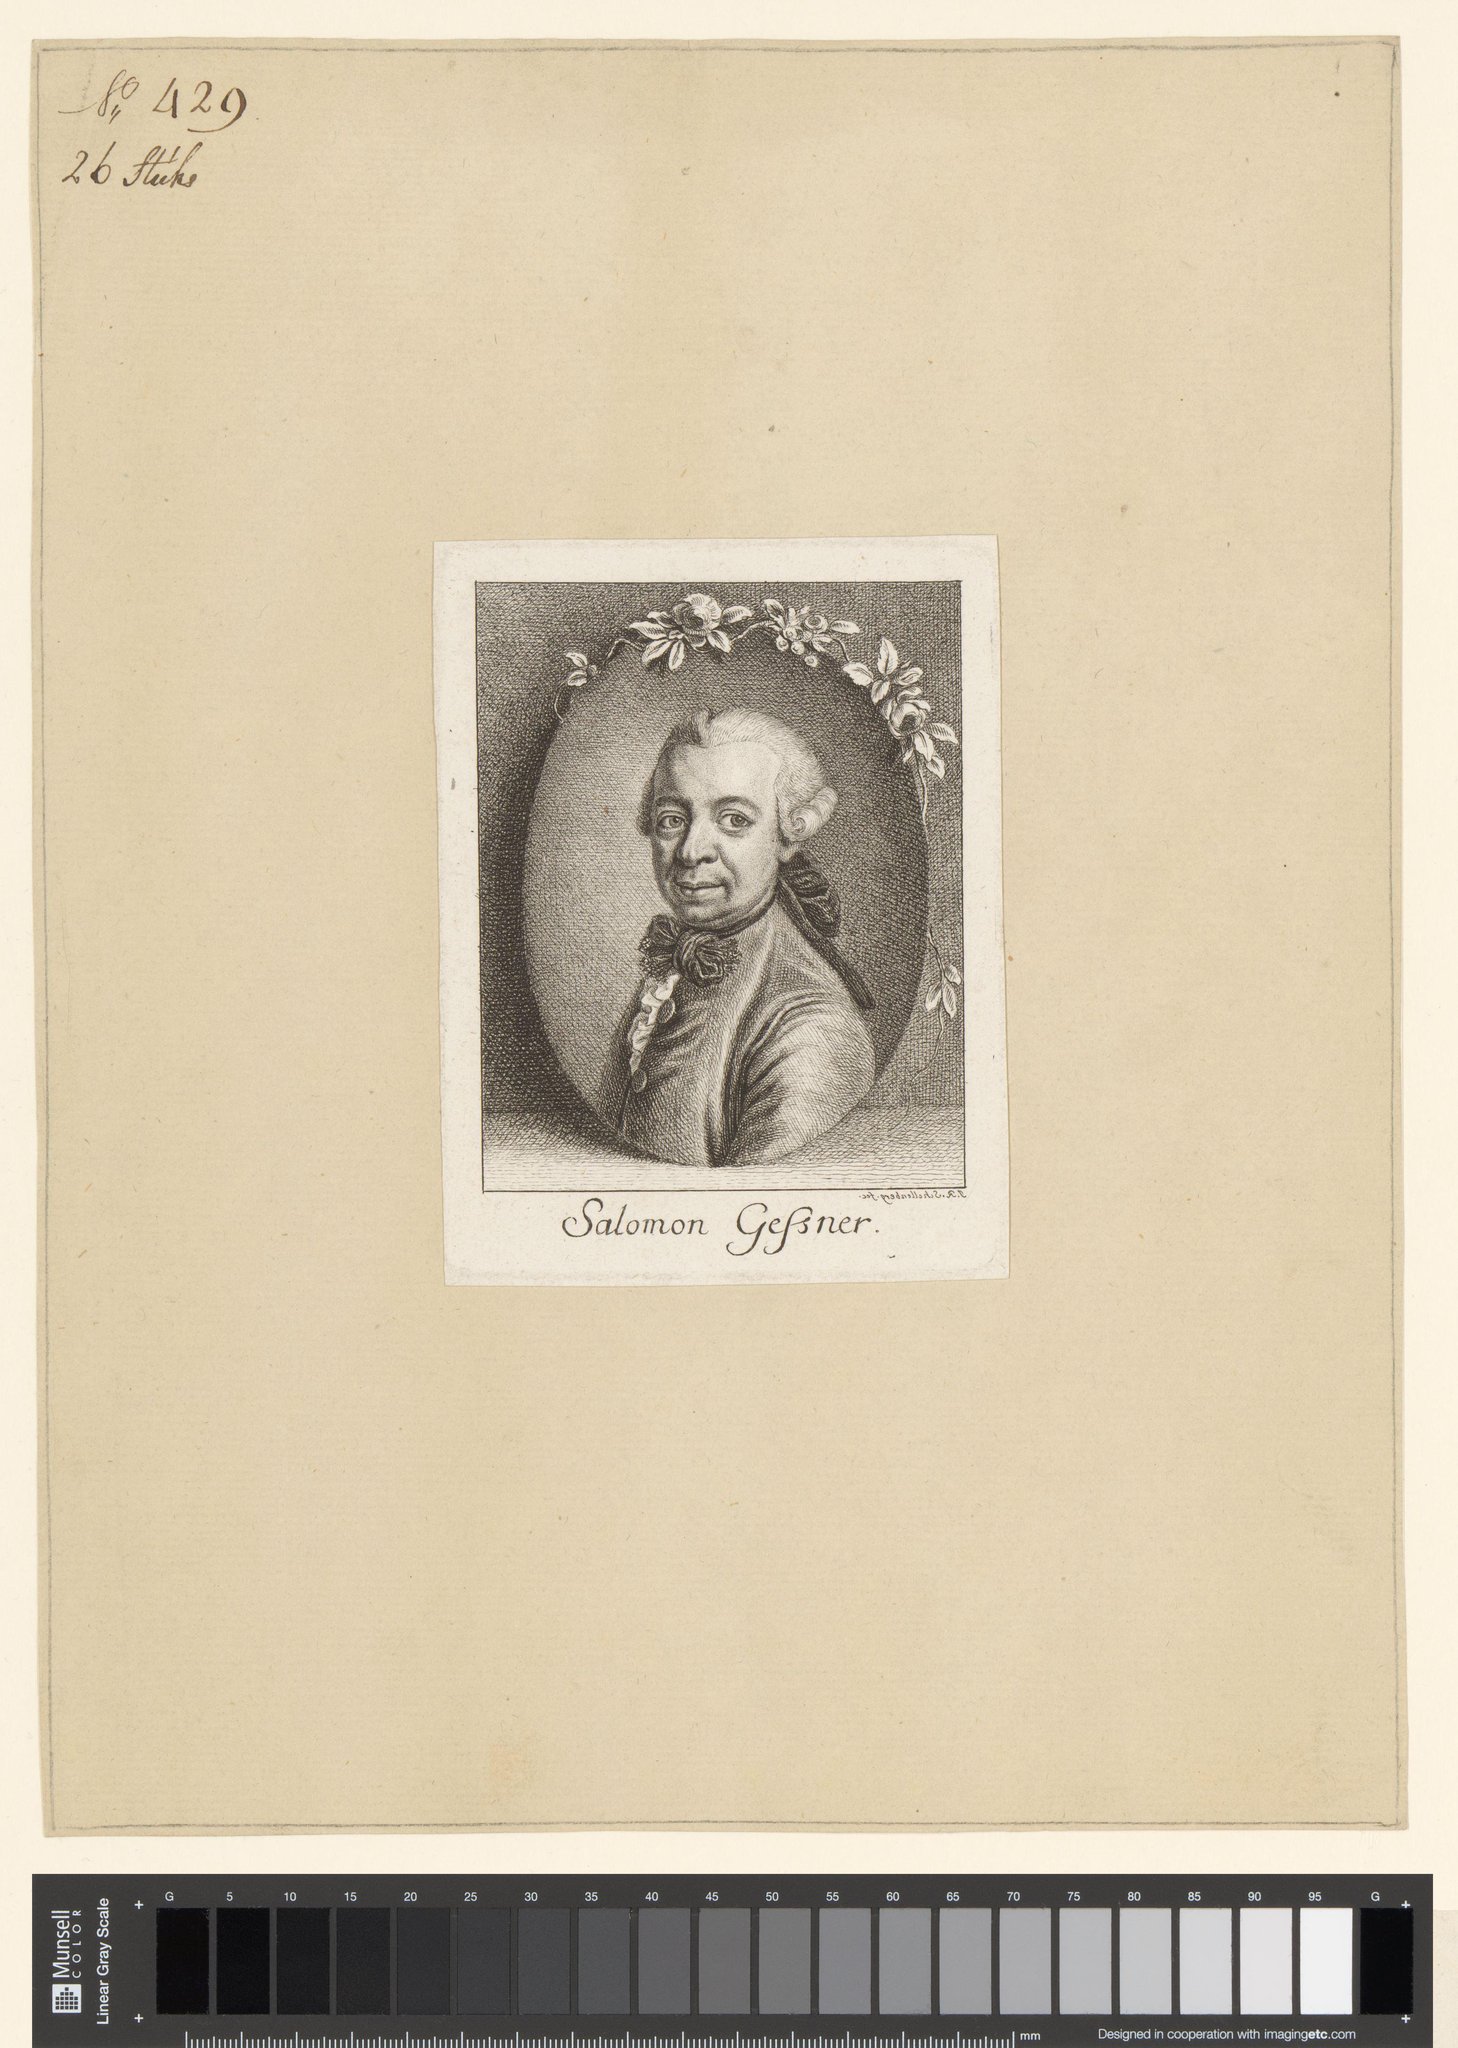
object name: print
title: Portret van Salomon Gessner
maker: johann rudolph schellenberg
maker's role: print maker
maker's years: 1740-1806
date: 1750-1806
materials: paper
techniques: etching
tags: painter, print maker, salomon gessner, portrait, self-portrait of artist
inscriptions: collector's mark: Lugt 2228